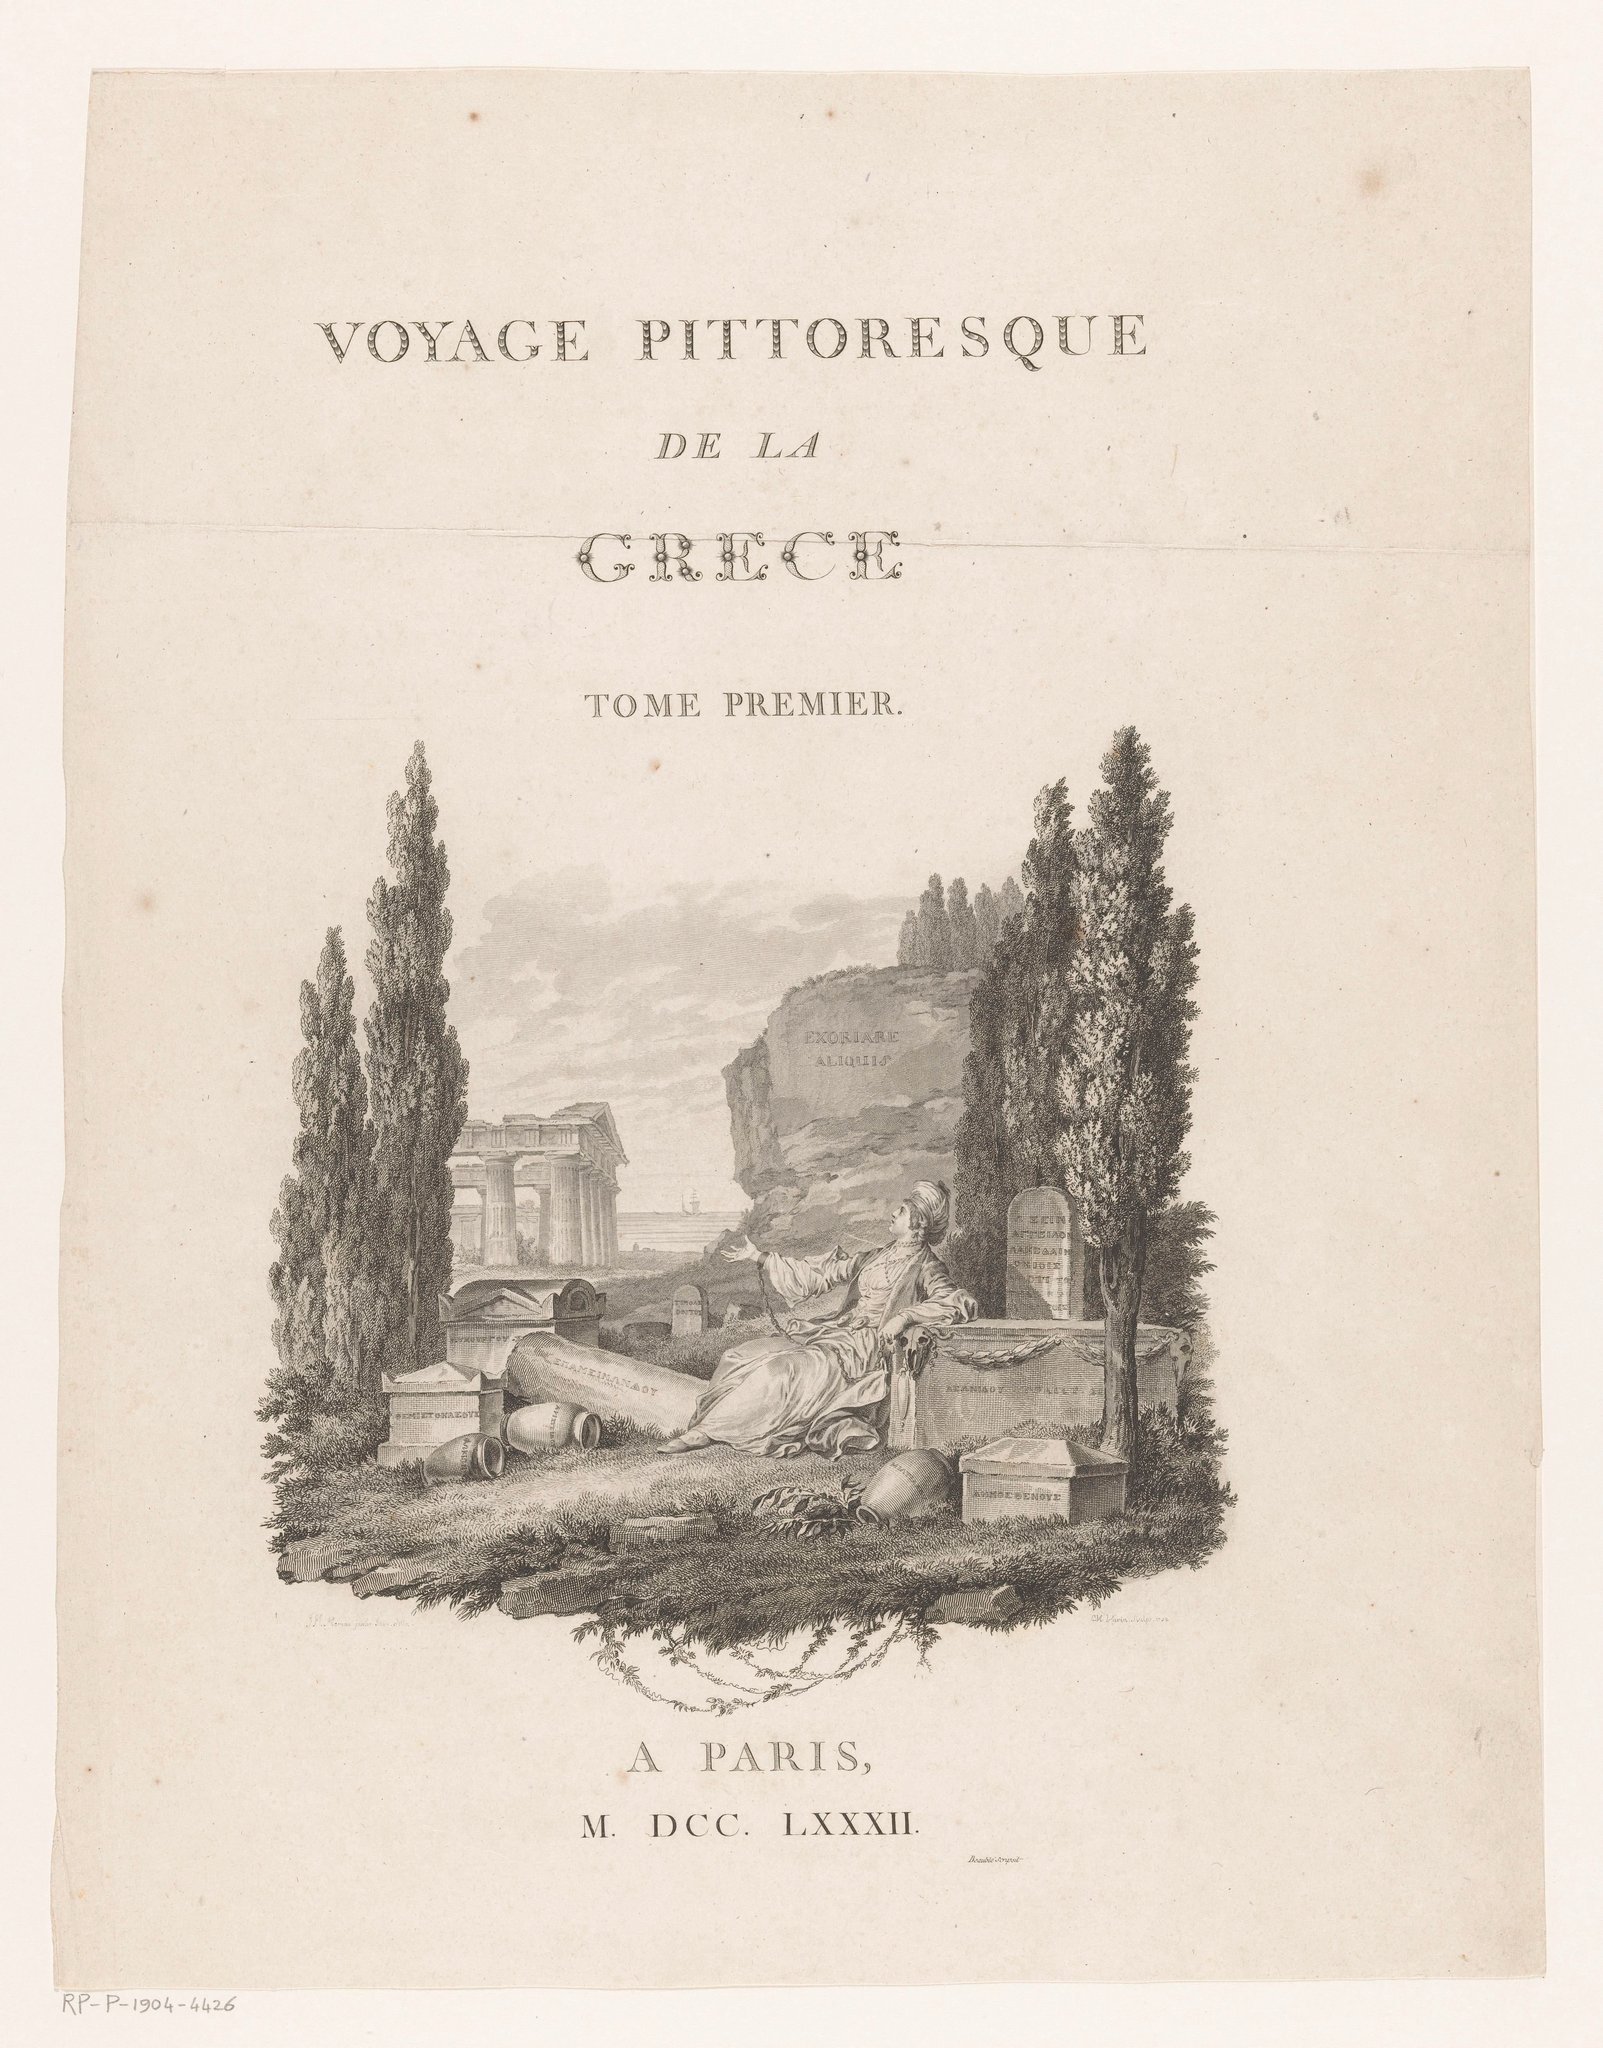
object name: titelblad, titelpagina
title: Titelpagina voor: Marie-Gabriel-Florent-Auguste de Choiseul-Gouffier, Voyage pittoresque de la Grèce, 1782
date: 1782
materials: paper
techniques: engraving, etching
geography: france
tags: landscapes with waters, waterscapes, seascapes (in the temperate zone), landscape with ruins, churchyard, cemetery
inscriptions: collector's mark: Lugt 2228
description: Titelpagina voor: Marie-Gabriel-Florent-Choiseul-Gouffier, Voyage pittoresque de la Grèce, vol. 1. Parijs: J.J. Blaise, 1782.